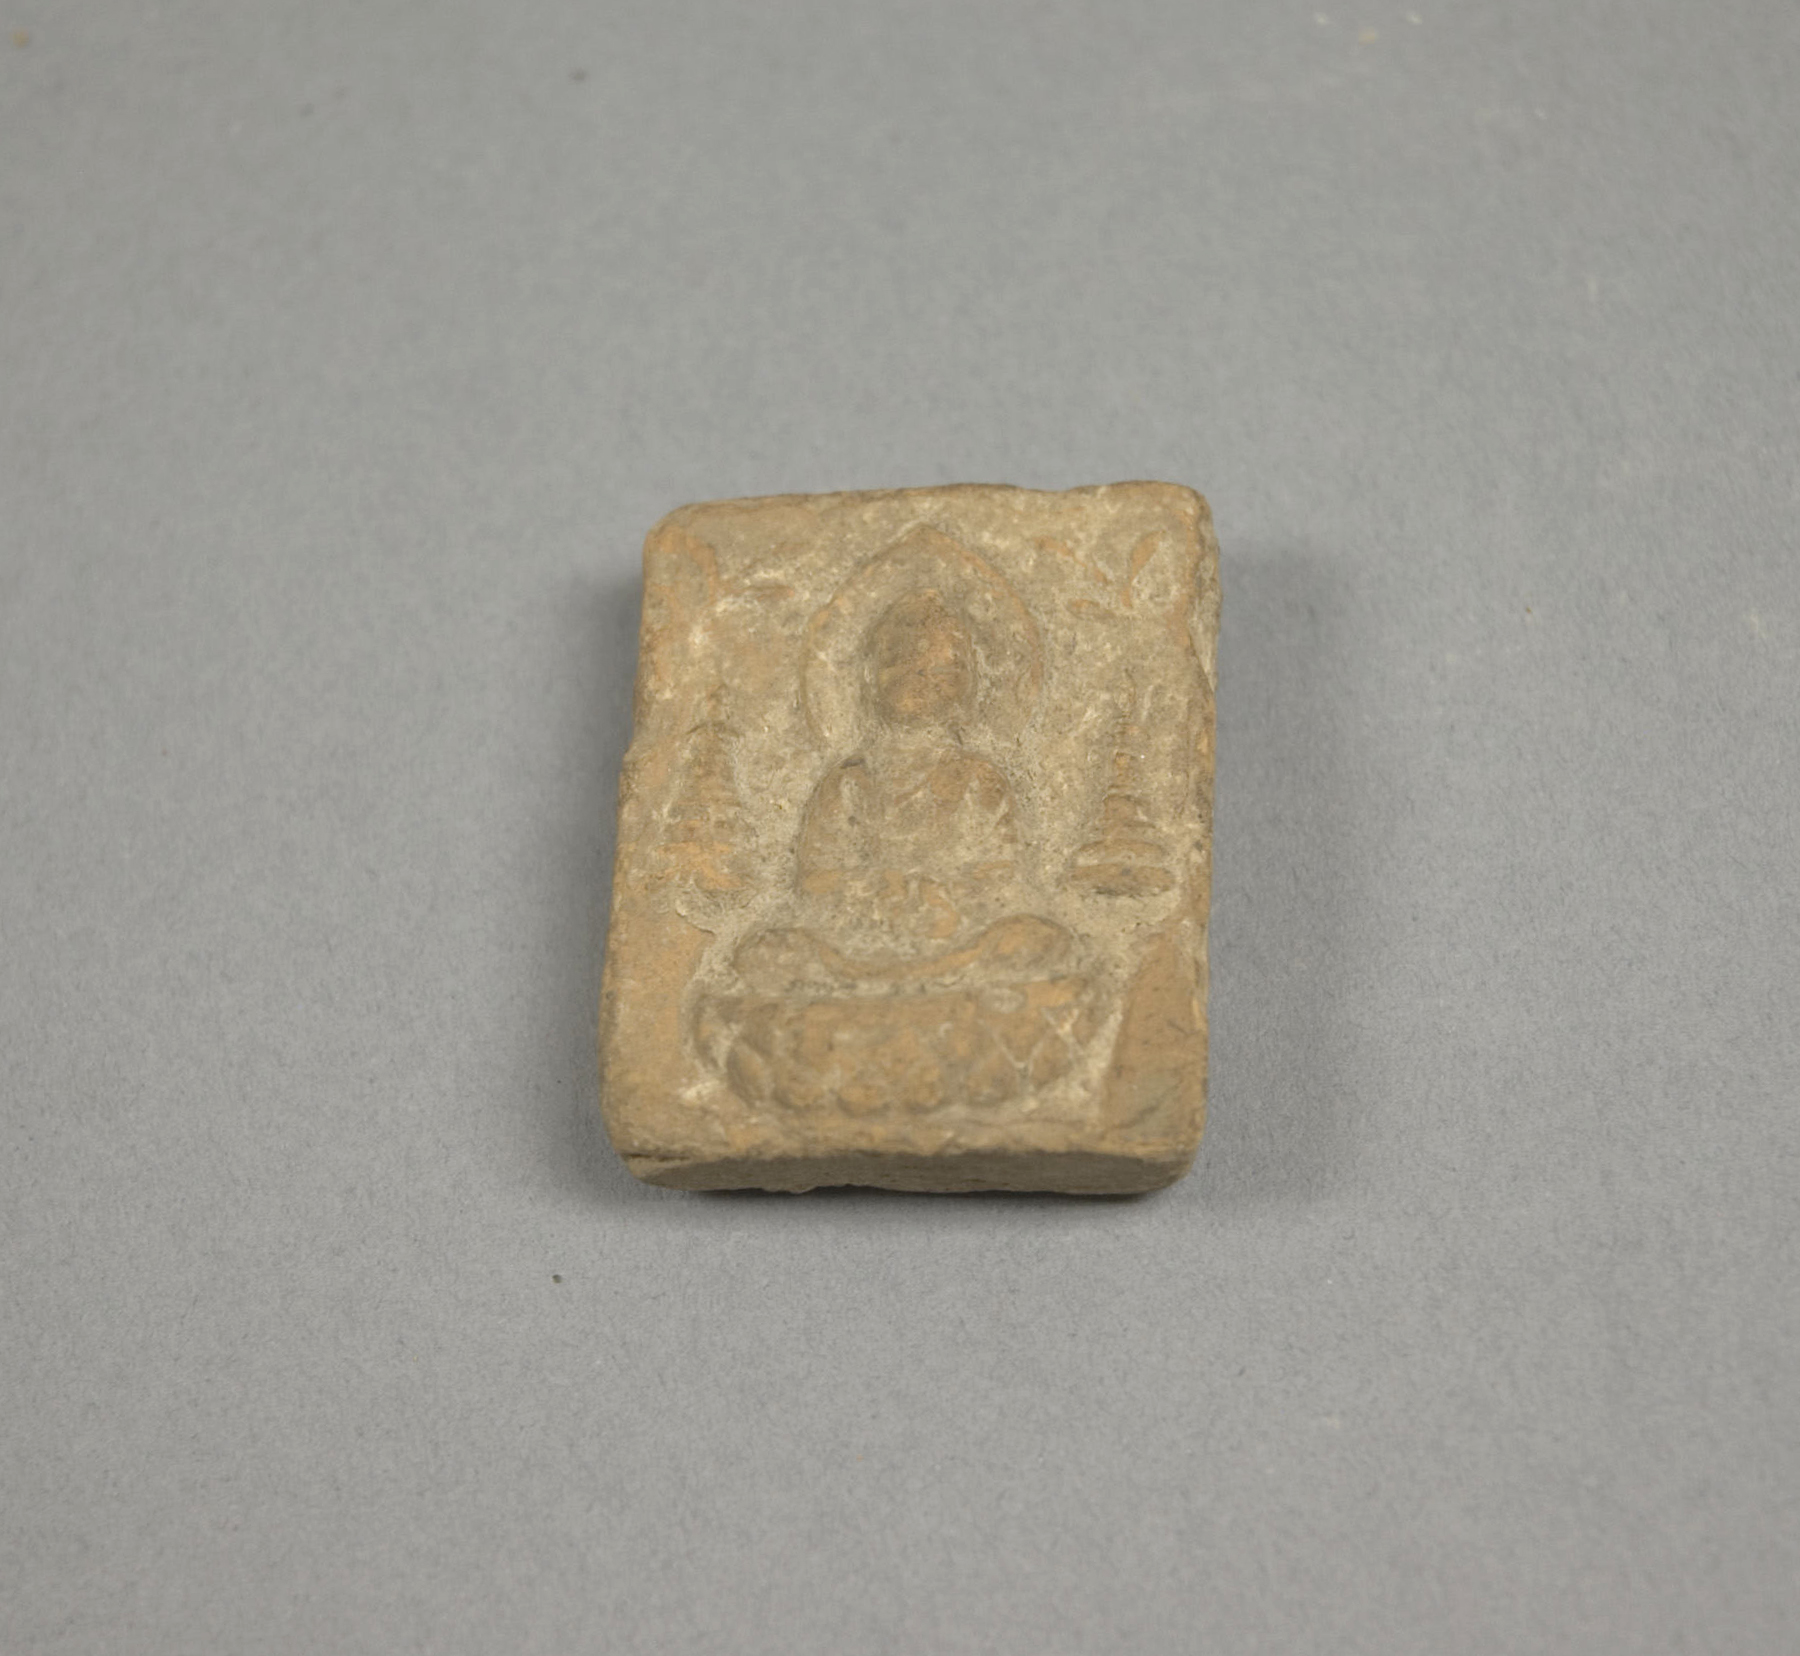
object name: plaque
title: Votive Plaque with Seated Buddhas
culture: tibetan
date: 618-906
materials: terracotta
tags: buddhism,buddha